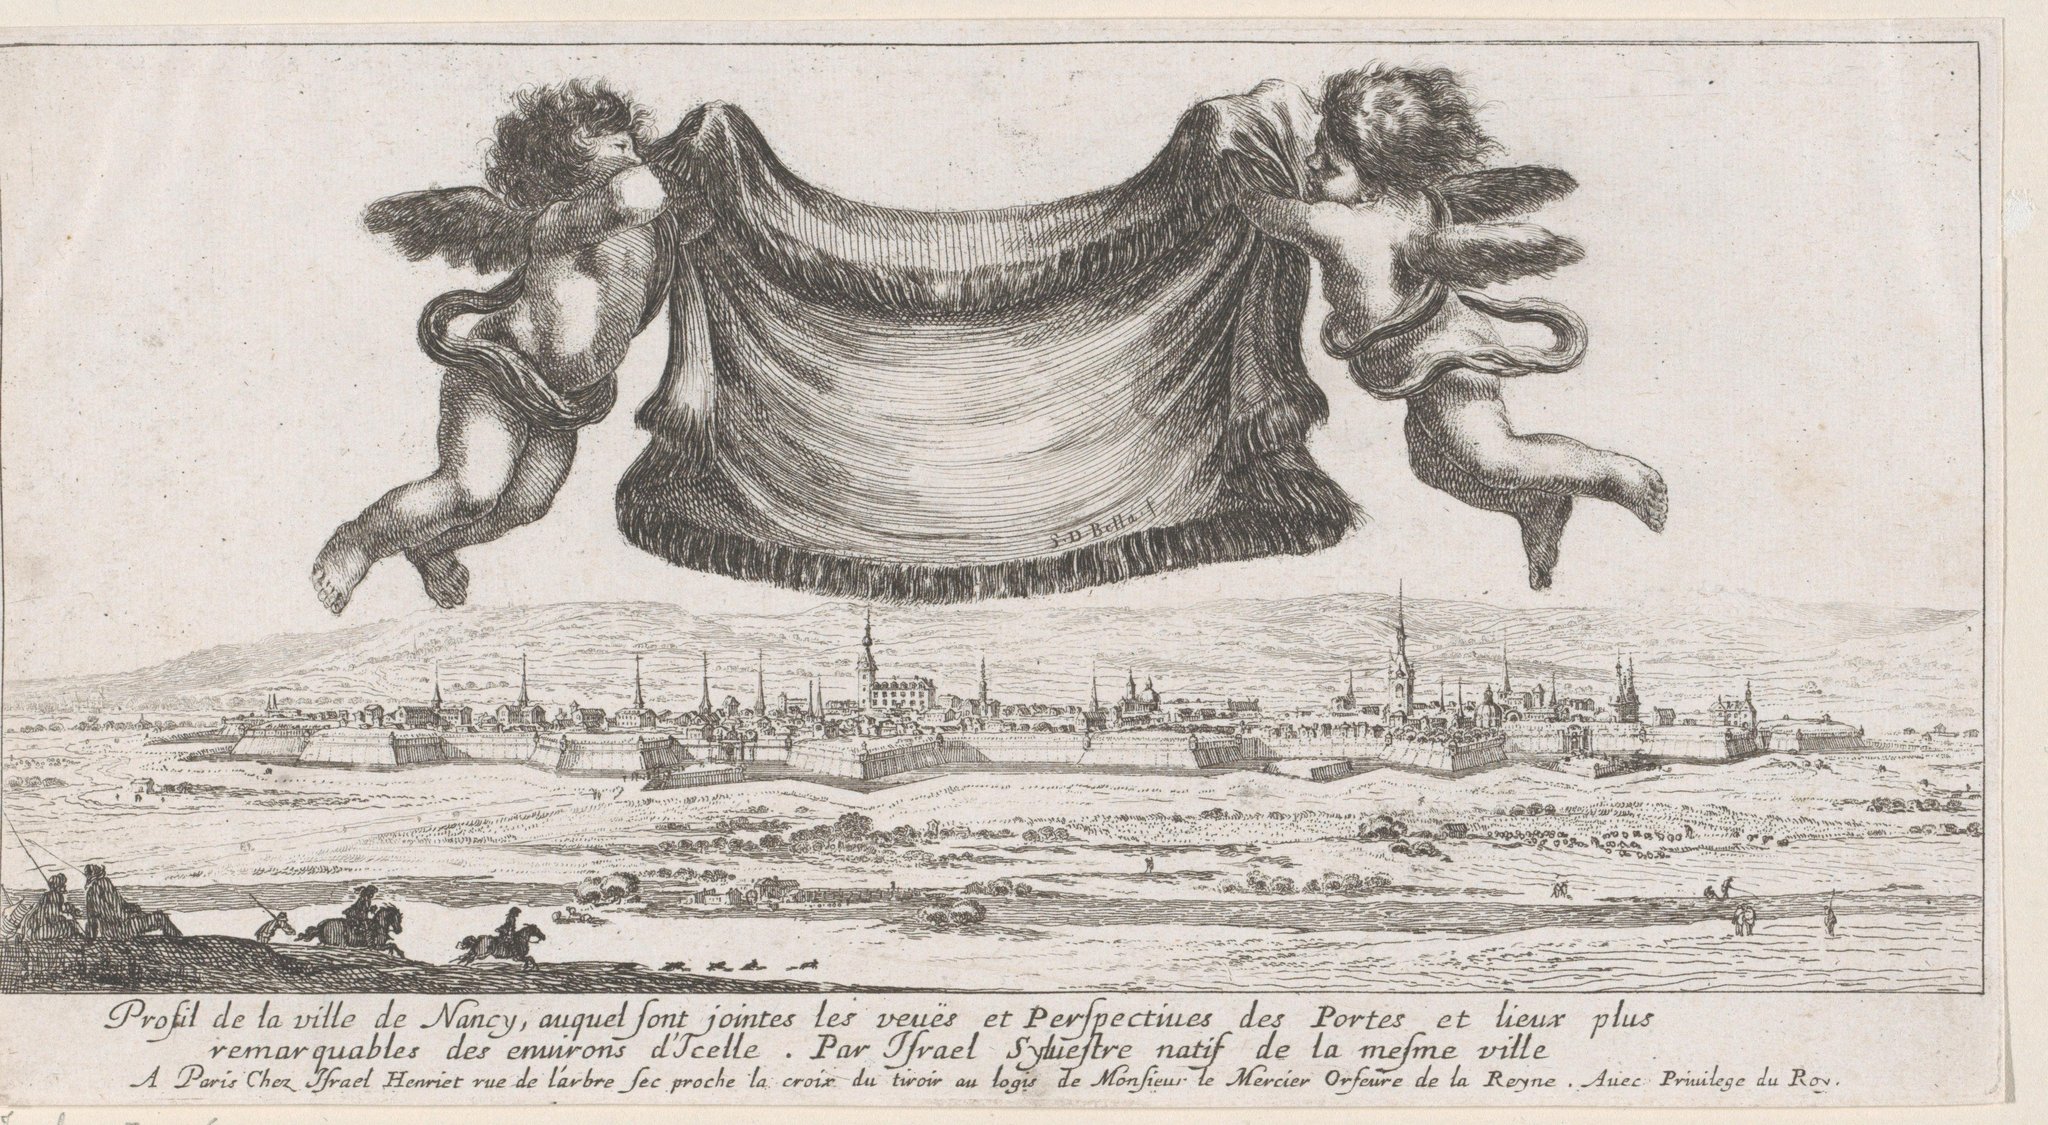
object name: print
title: Gezicht op Nancy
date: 1620-1664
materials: paper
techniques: etching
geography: france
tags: city-view, and landscape with man-made constructions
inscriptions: collector's mark: Lugt 240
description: Twee zwevende putti die samen een doek omhoog houden. Op de achtergrond een gezicht op de stad Nancy. Tekst in de ondermarge in het Frans.